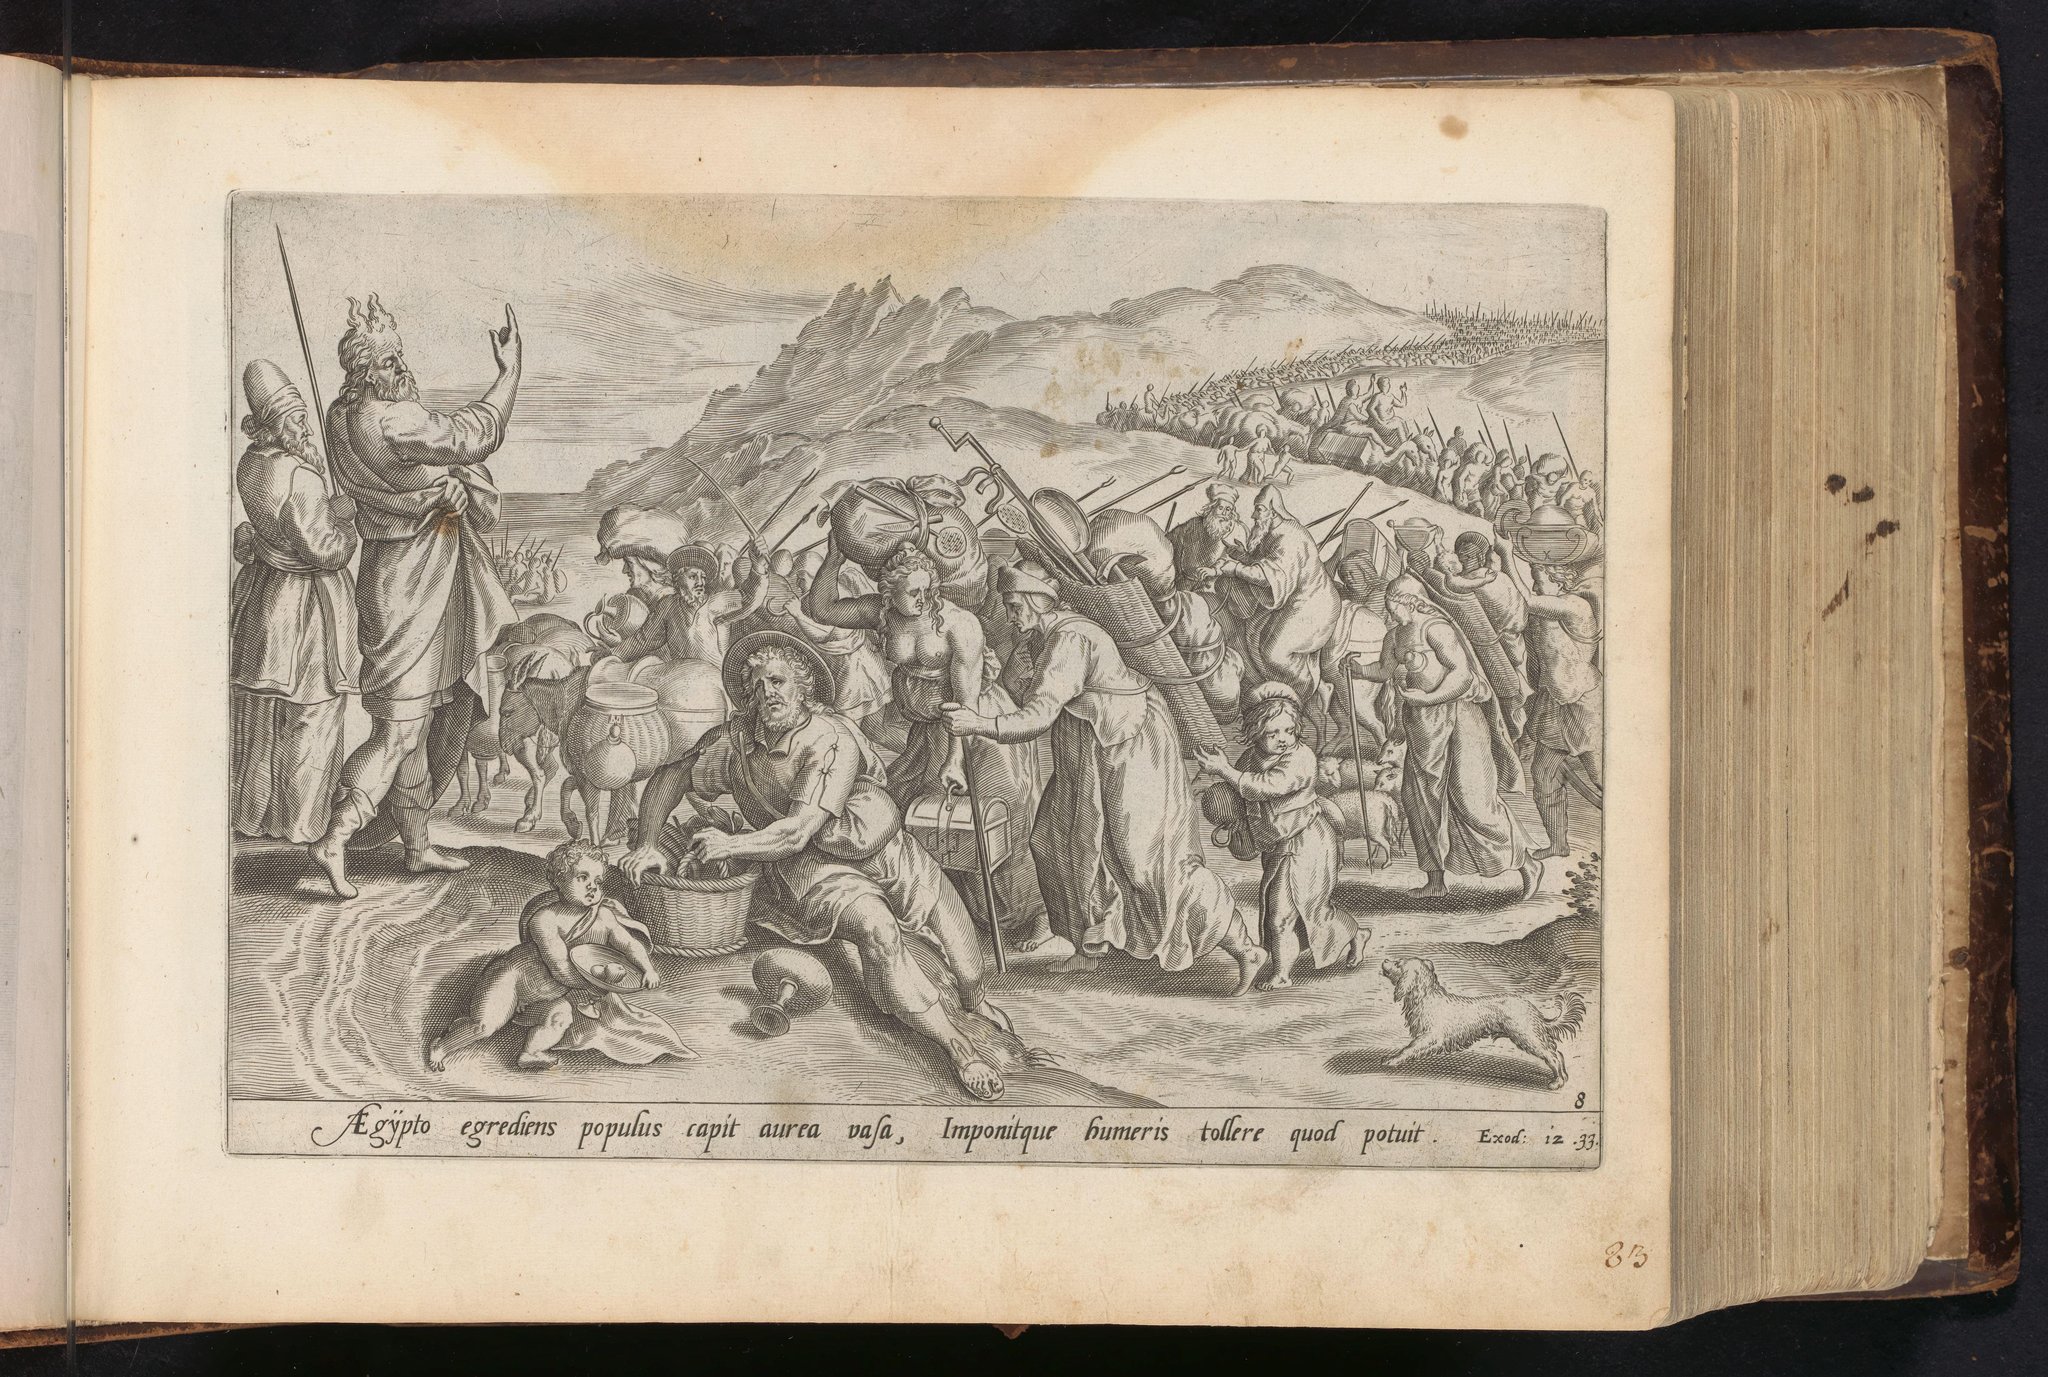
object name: album leaf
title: Geschiedenis van Mozes voor de Exodus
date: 1579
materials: paper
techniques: engraving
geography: alkmaar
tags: the israelites leave egypt; first movement from rameses to succoth (exodus 12:31 - 13:16)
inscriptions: number: ‘83’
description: Op de voorgrond Mozes en Aäron die het volk van Israël uit Egypte leiden. Het Joodse volk trekt in een lange stoet met al hun bezittingen naar de Rode Zee. Onder de voorstelling een verwijzing in het Latijn naar de Bijbeltekst in Ex. 12:33. Deze prent maakt deel uit van een album.